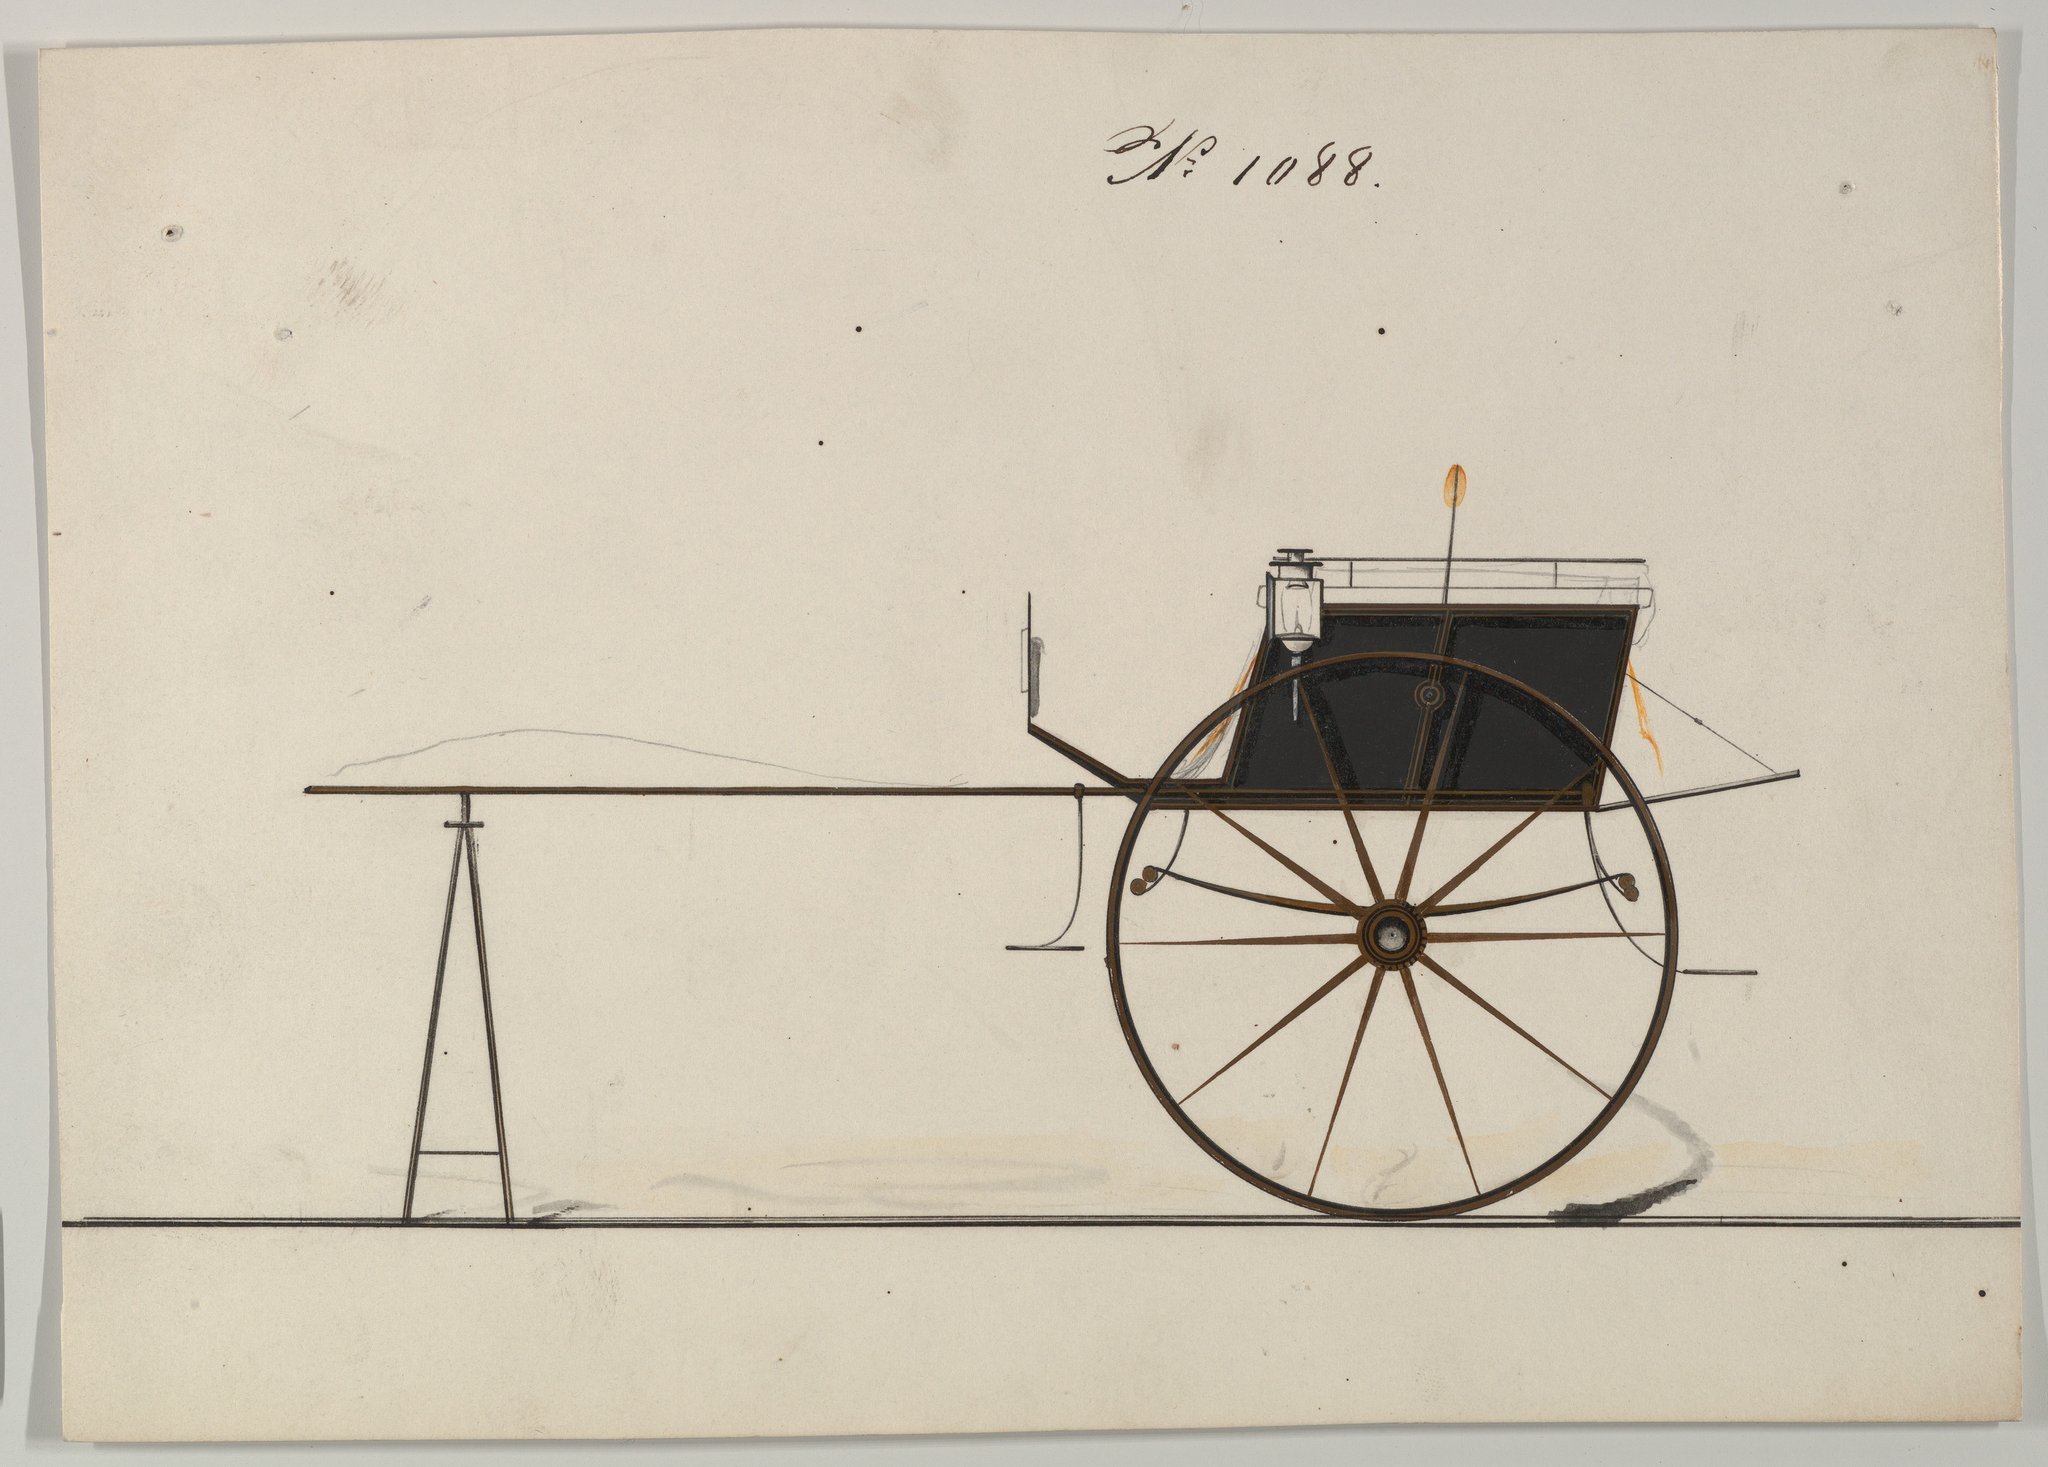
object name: drawing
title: Dog CArt #1088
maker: brewster & co.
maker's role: manufacturer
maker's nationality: american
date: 1870-1874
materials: gouache, graphite, gum arabic, ink, watercolor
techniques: pen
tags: carriages